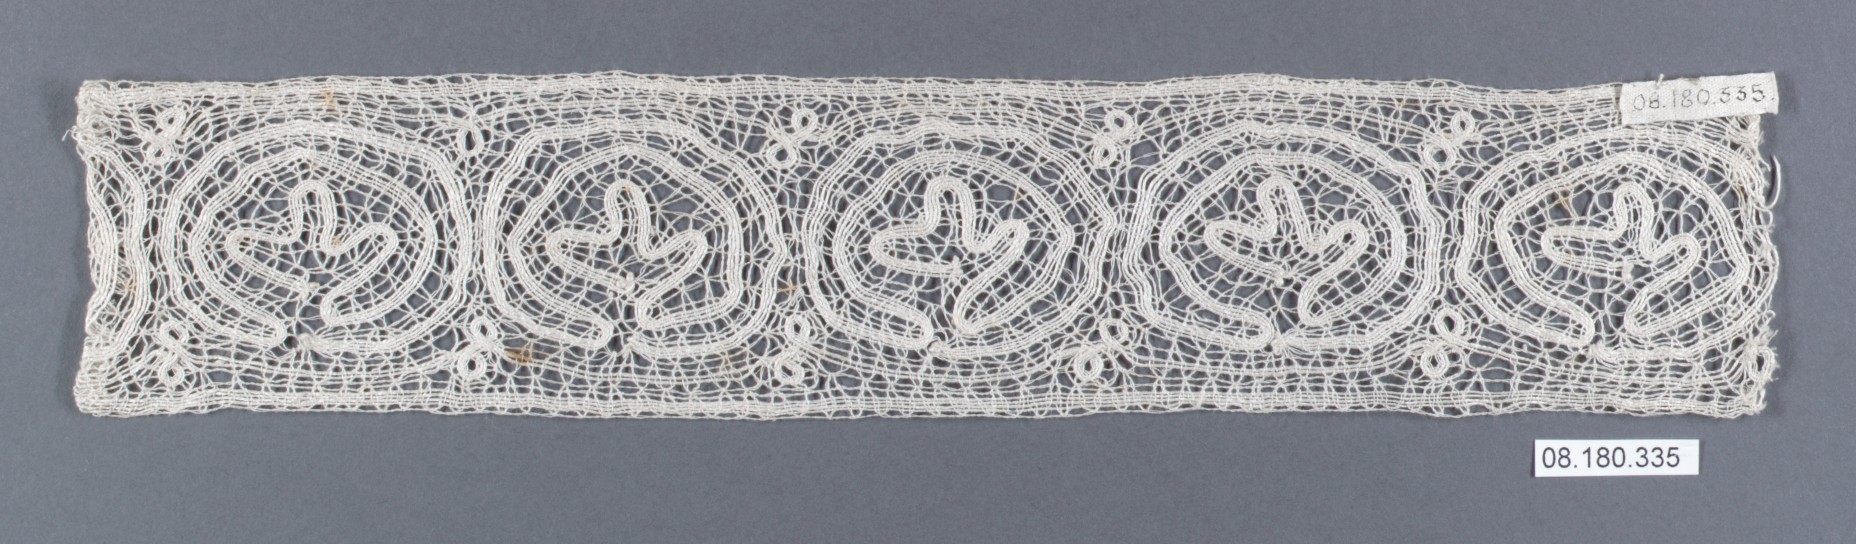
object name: insertion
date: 1801-1900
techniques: lace